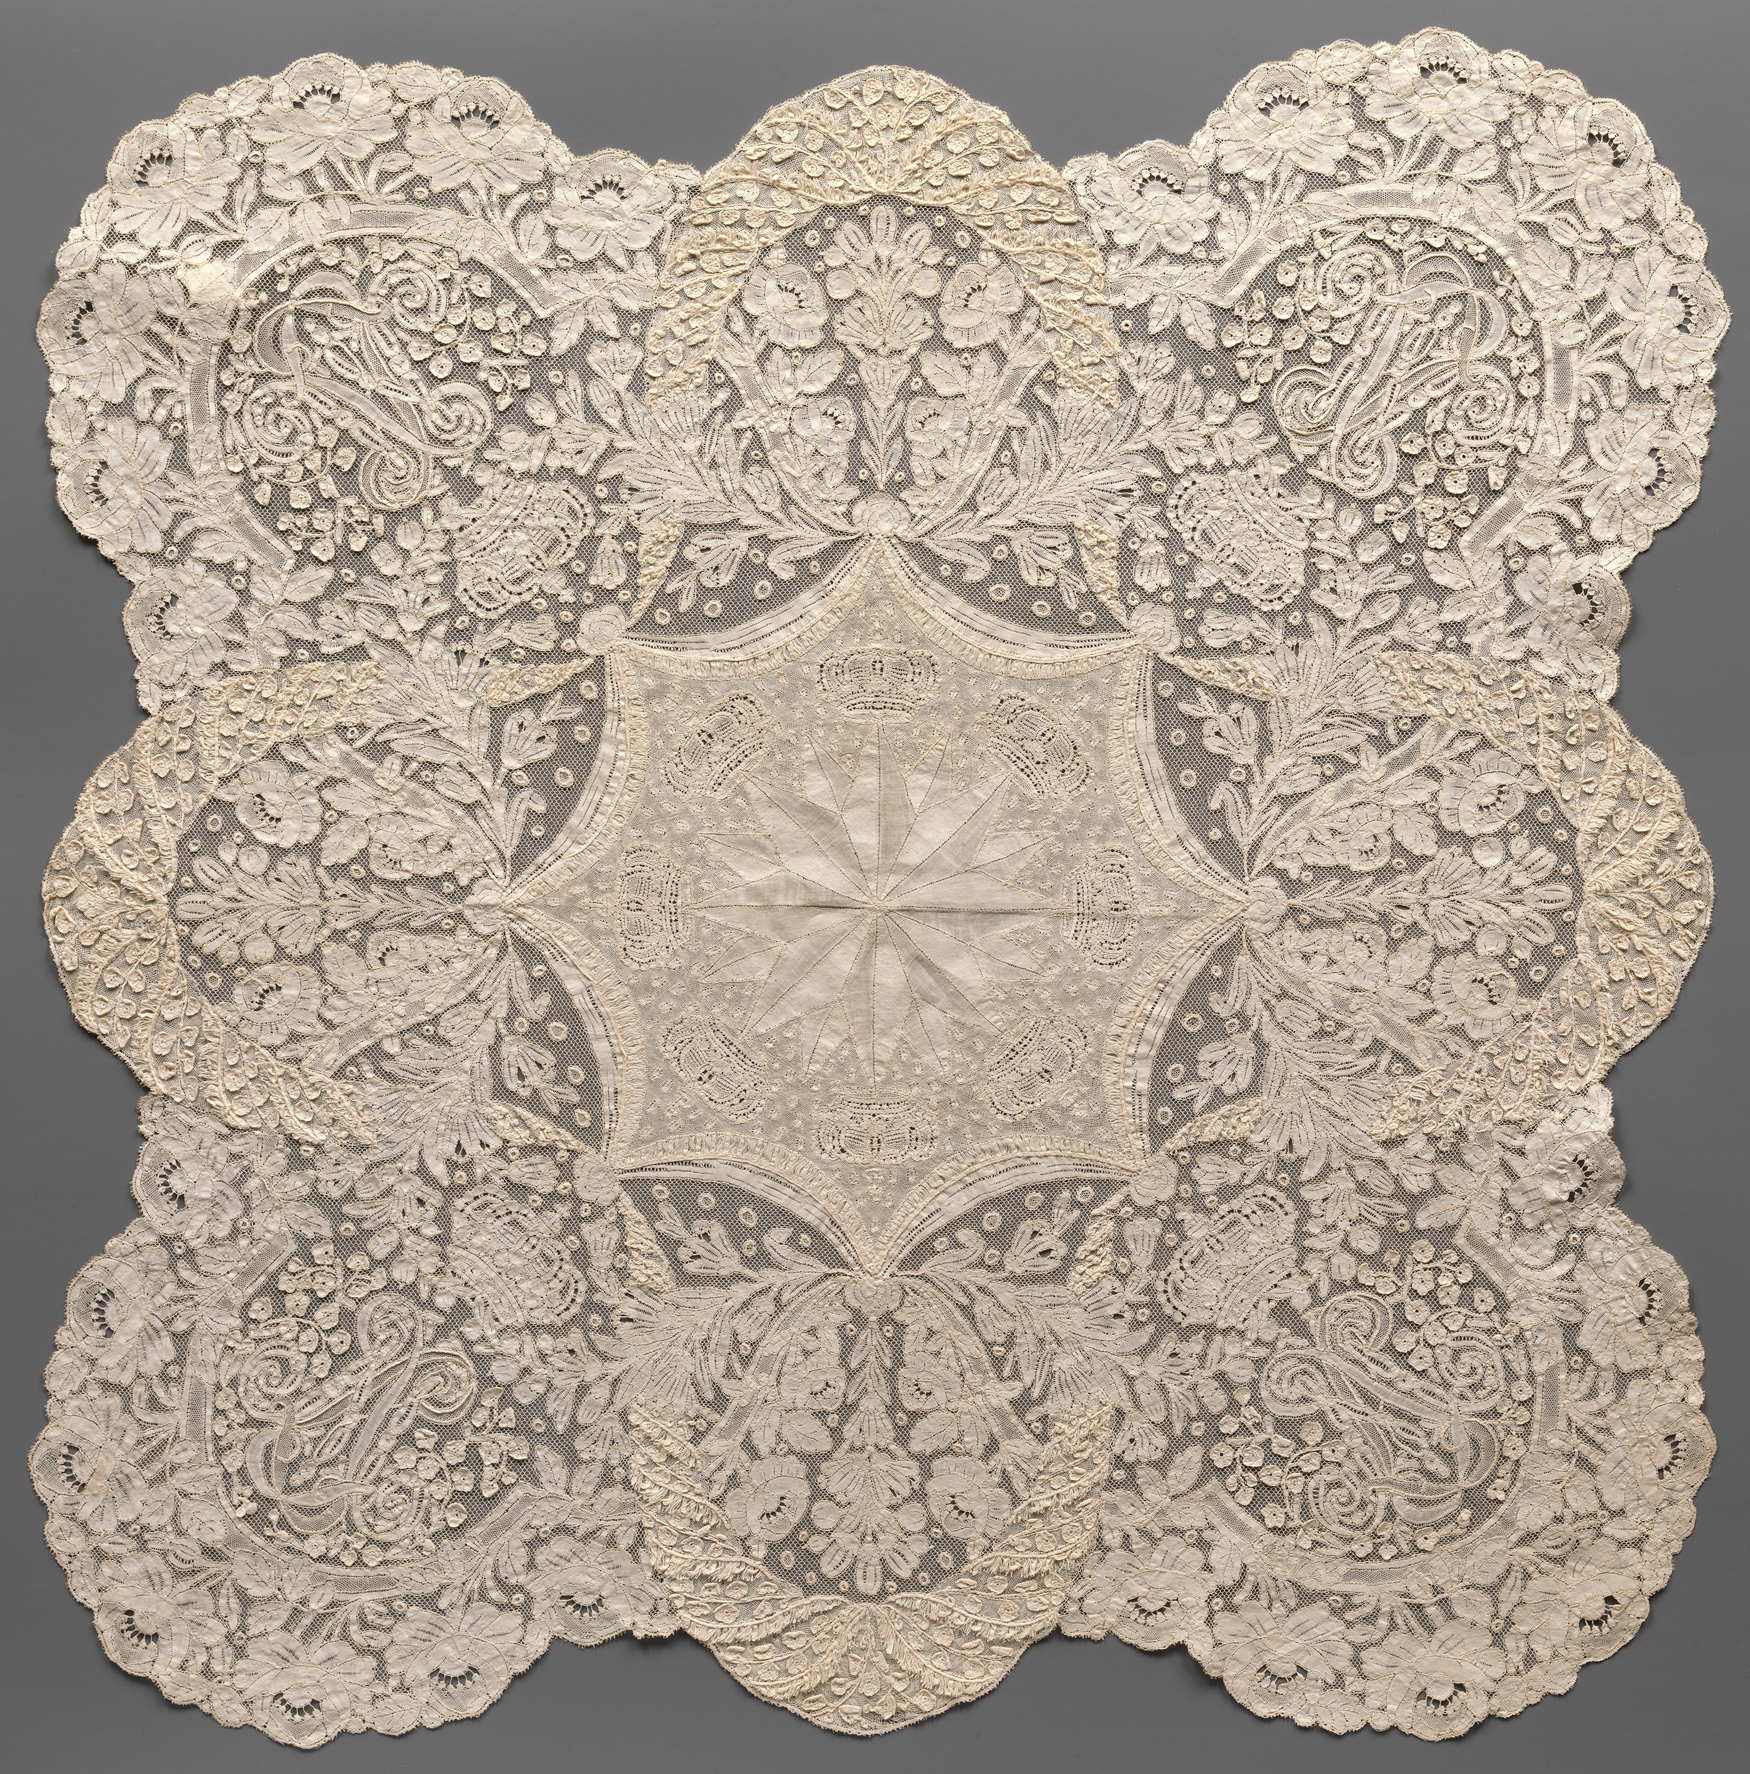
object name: handkerchief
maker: convent of notre dame de visitation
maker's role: maker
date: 1865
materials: cotton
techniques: lace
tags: flowers,leaves,insignia